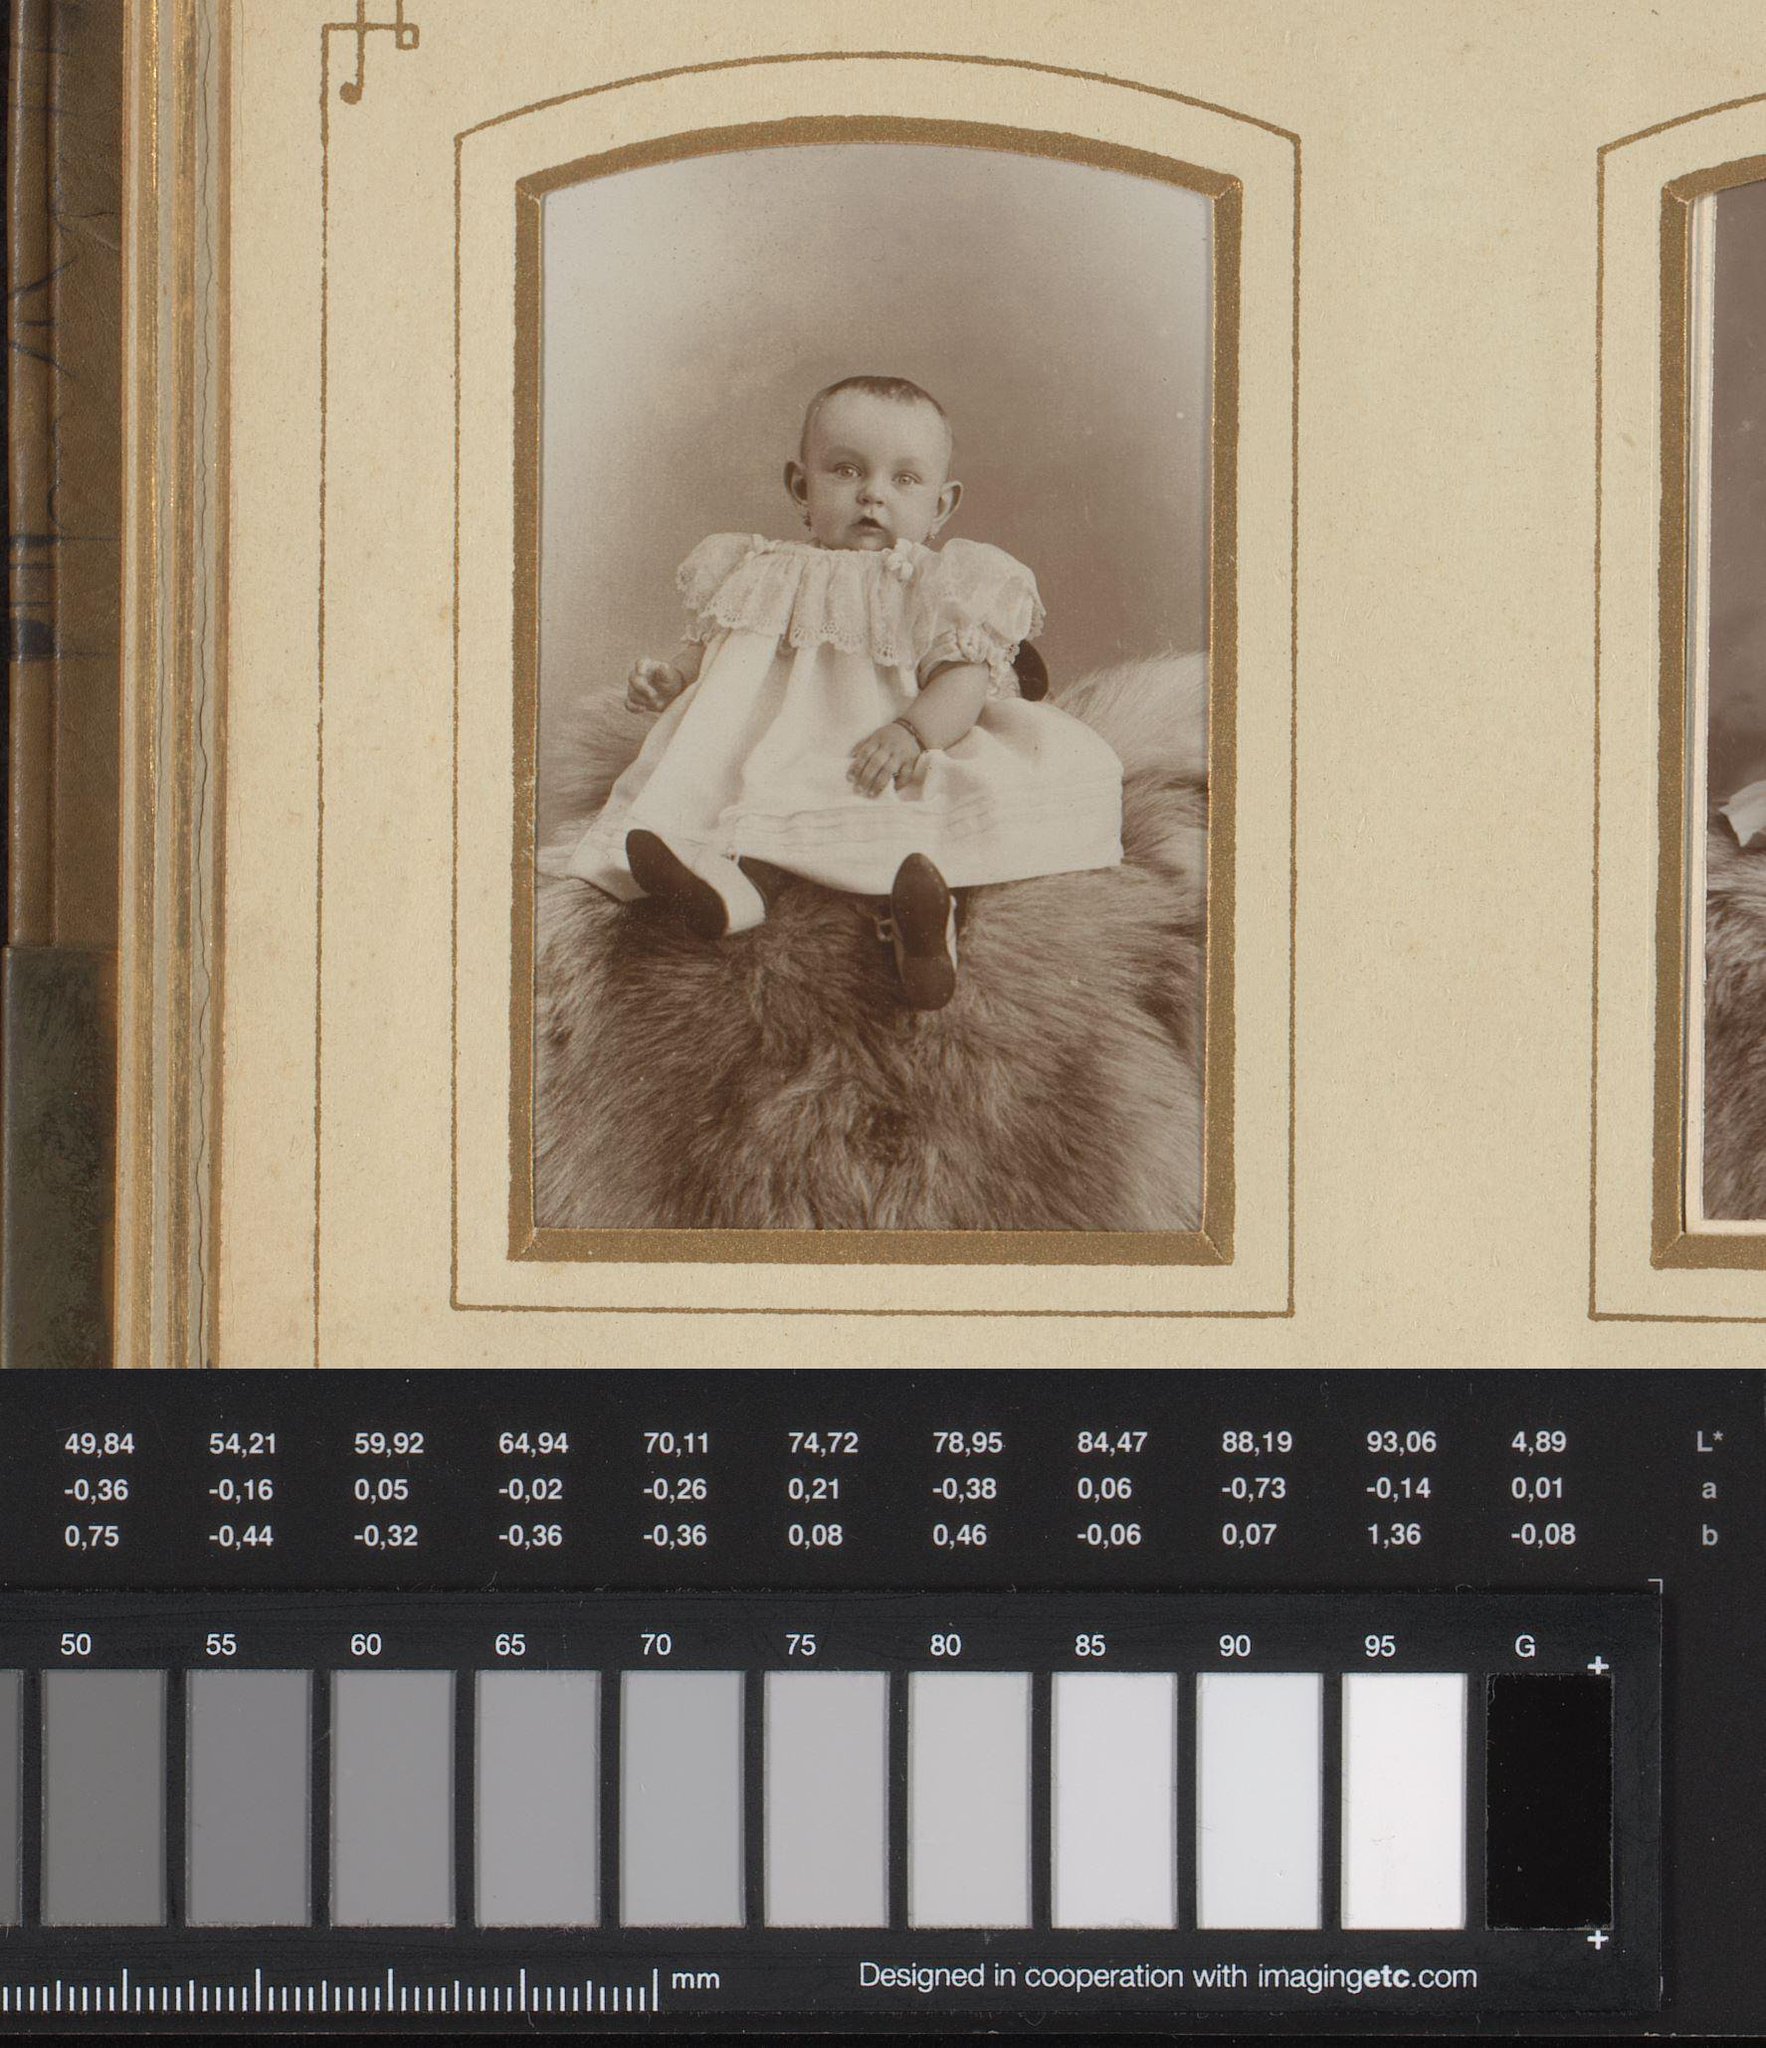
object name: album leaf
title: Portret van een zittende baby in witte jurk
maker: josephus hendrikus petrus coppens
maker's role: fotograaf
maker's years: 1864-1941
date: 1889-1925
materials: cardboard, photographic support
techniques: collodion silver print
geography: purmerend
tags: sitting figure, historical persons, infant, baby ~ the ages of man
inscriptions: inscription: ‘Levensgroote olieverfs/ Pastell en Craijon/ Portretten naar/ Photographie/ J. H. P. Coppens/ Photograaf/ en/ Portretschilder/ Purmerend./ Negatieven voor nabestelling bewaard.’